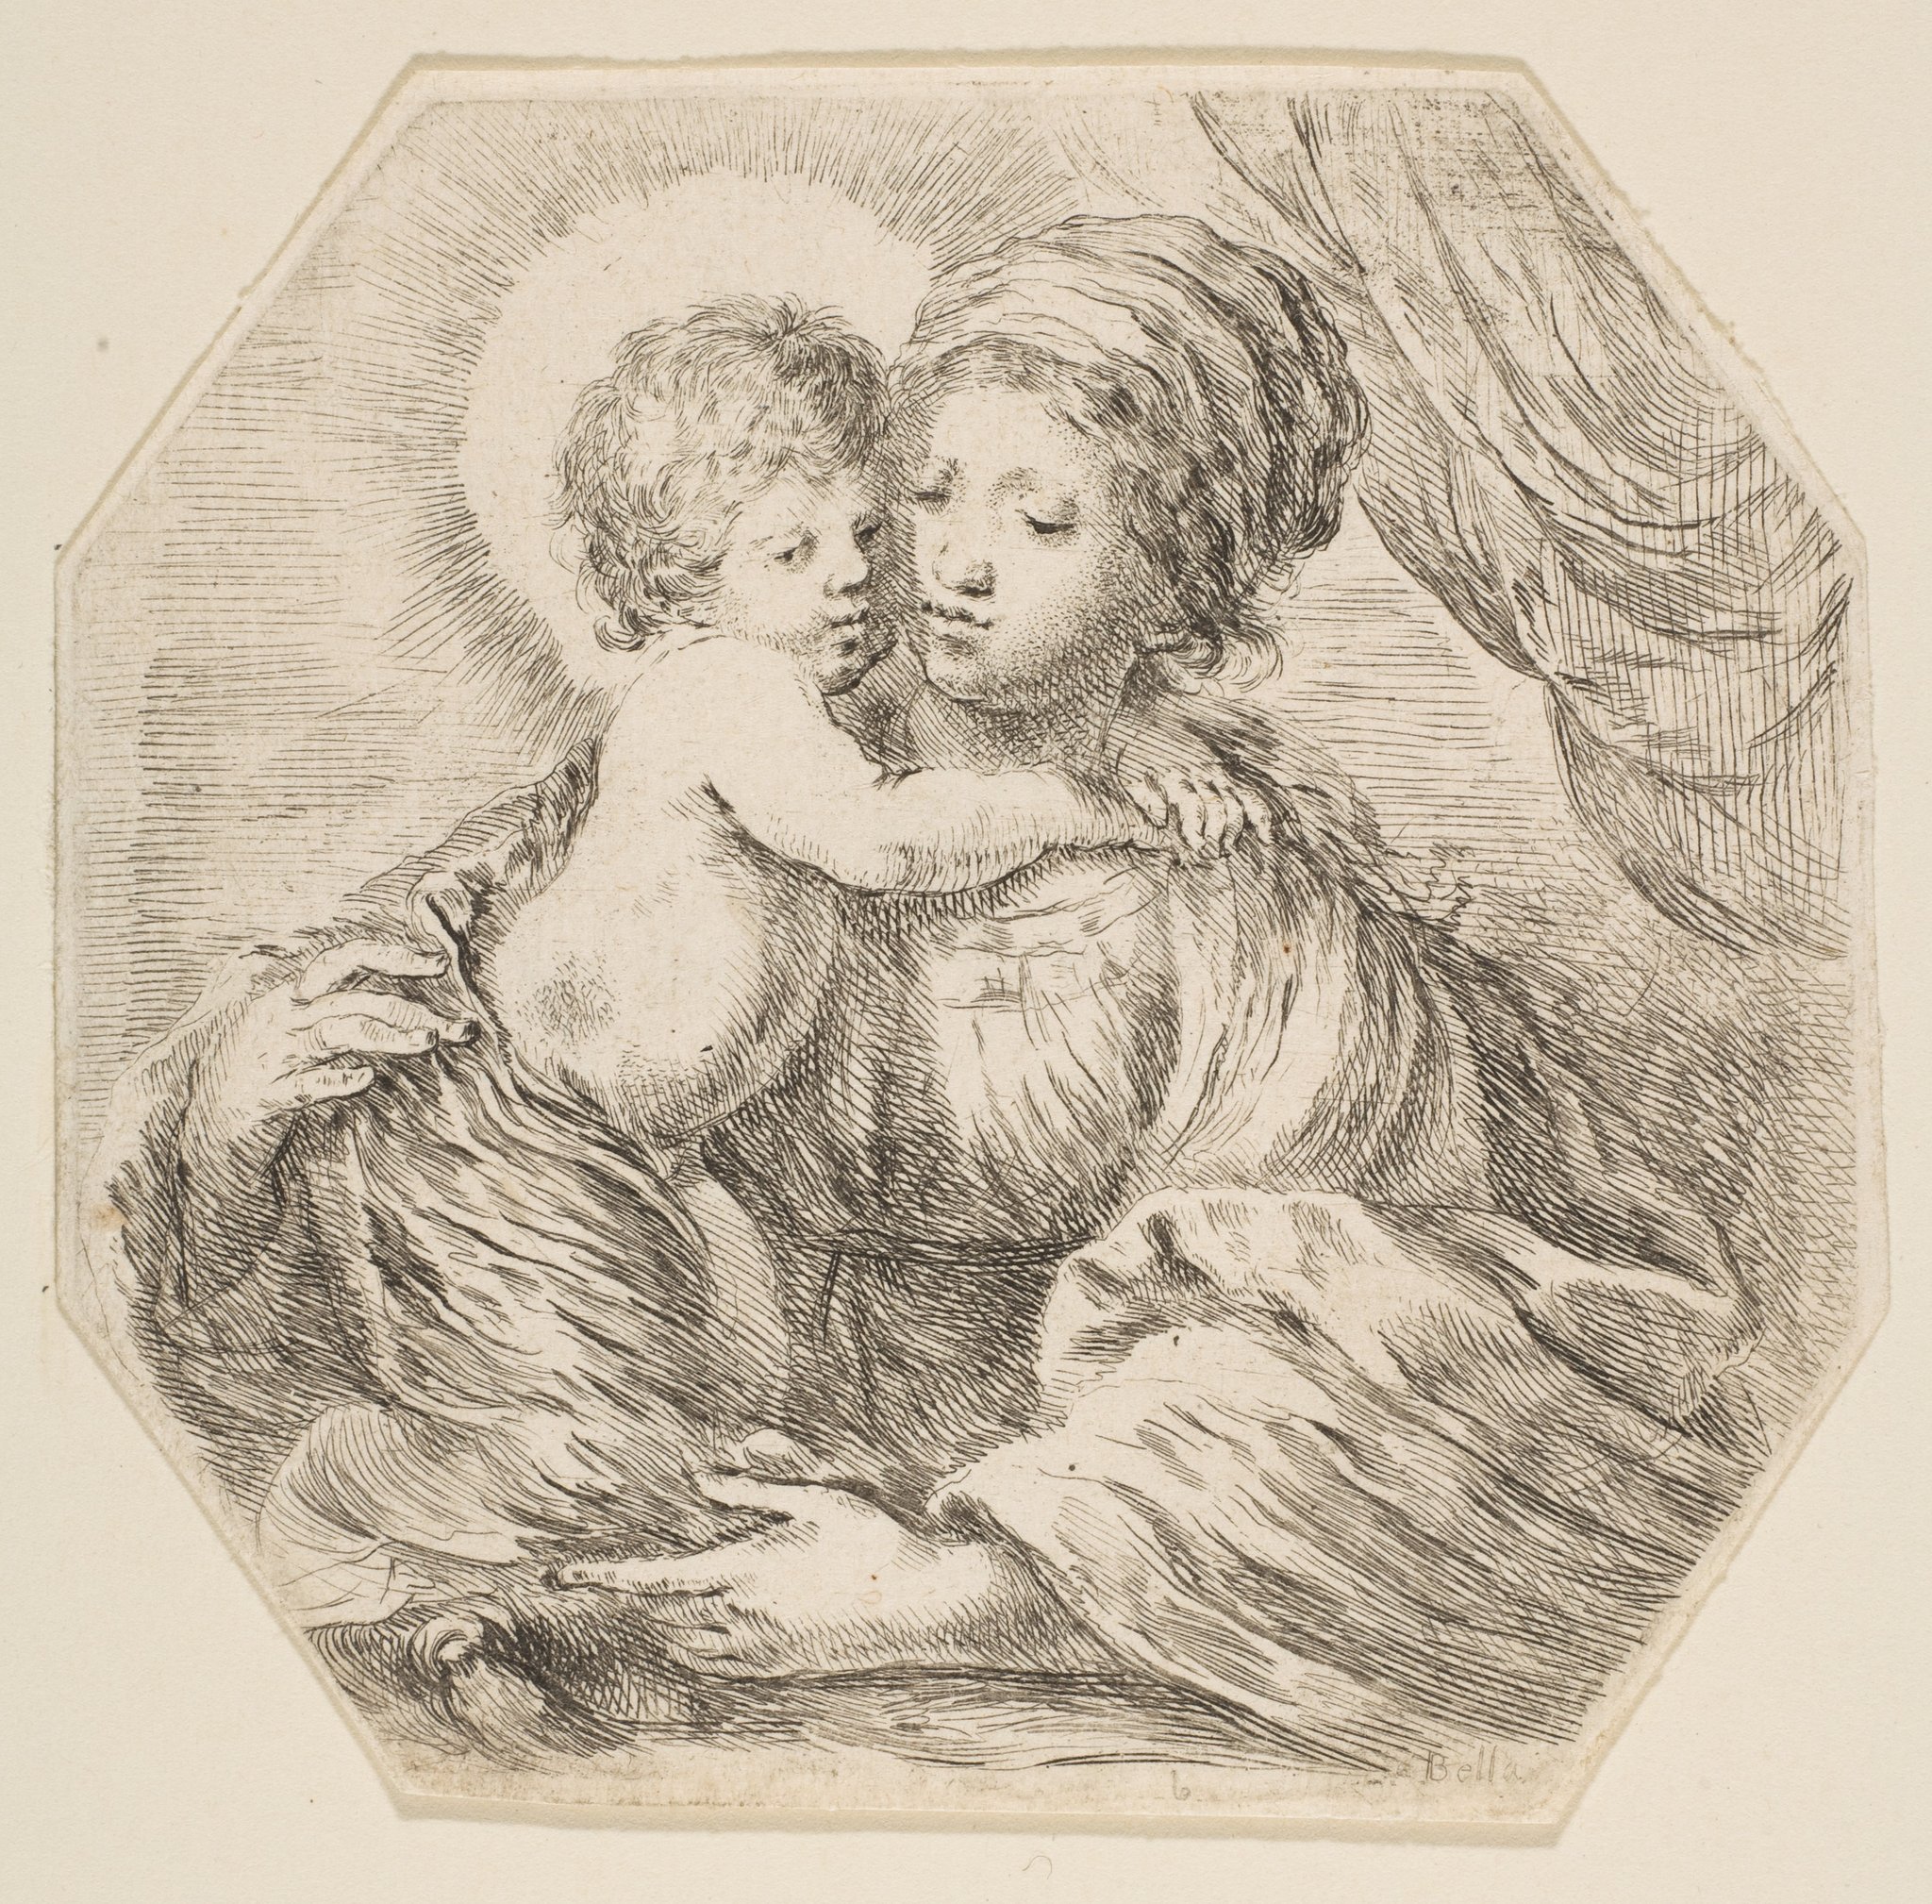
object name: print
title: Virgin and Christ Child, an octagonal composition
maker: stefano della bella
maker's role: artist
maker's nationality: italian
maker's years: 1610-1664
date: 1649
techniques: etching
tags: madonna and child